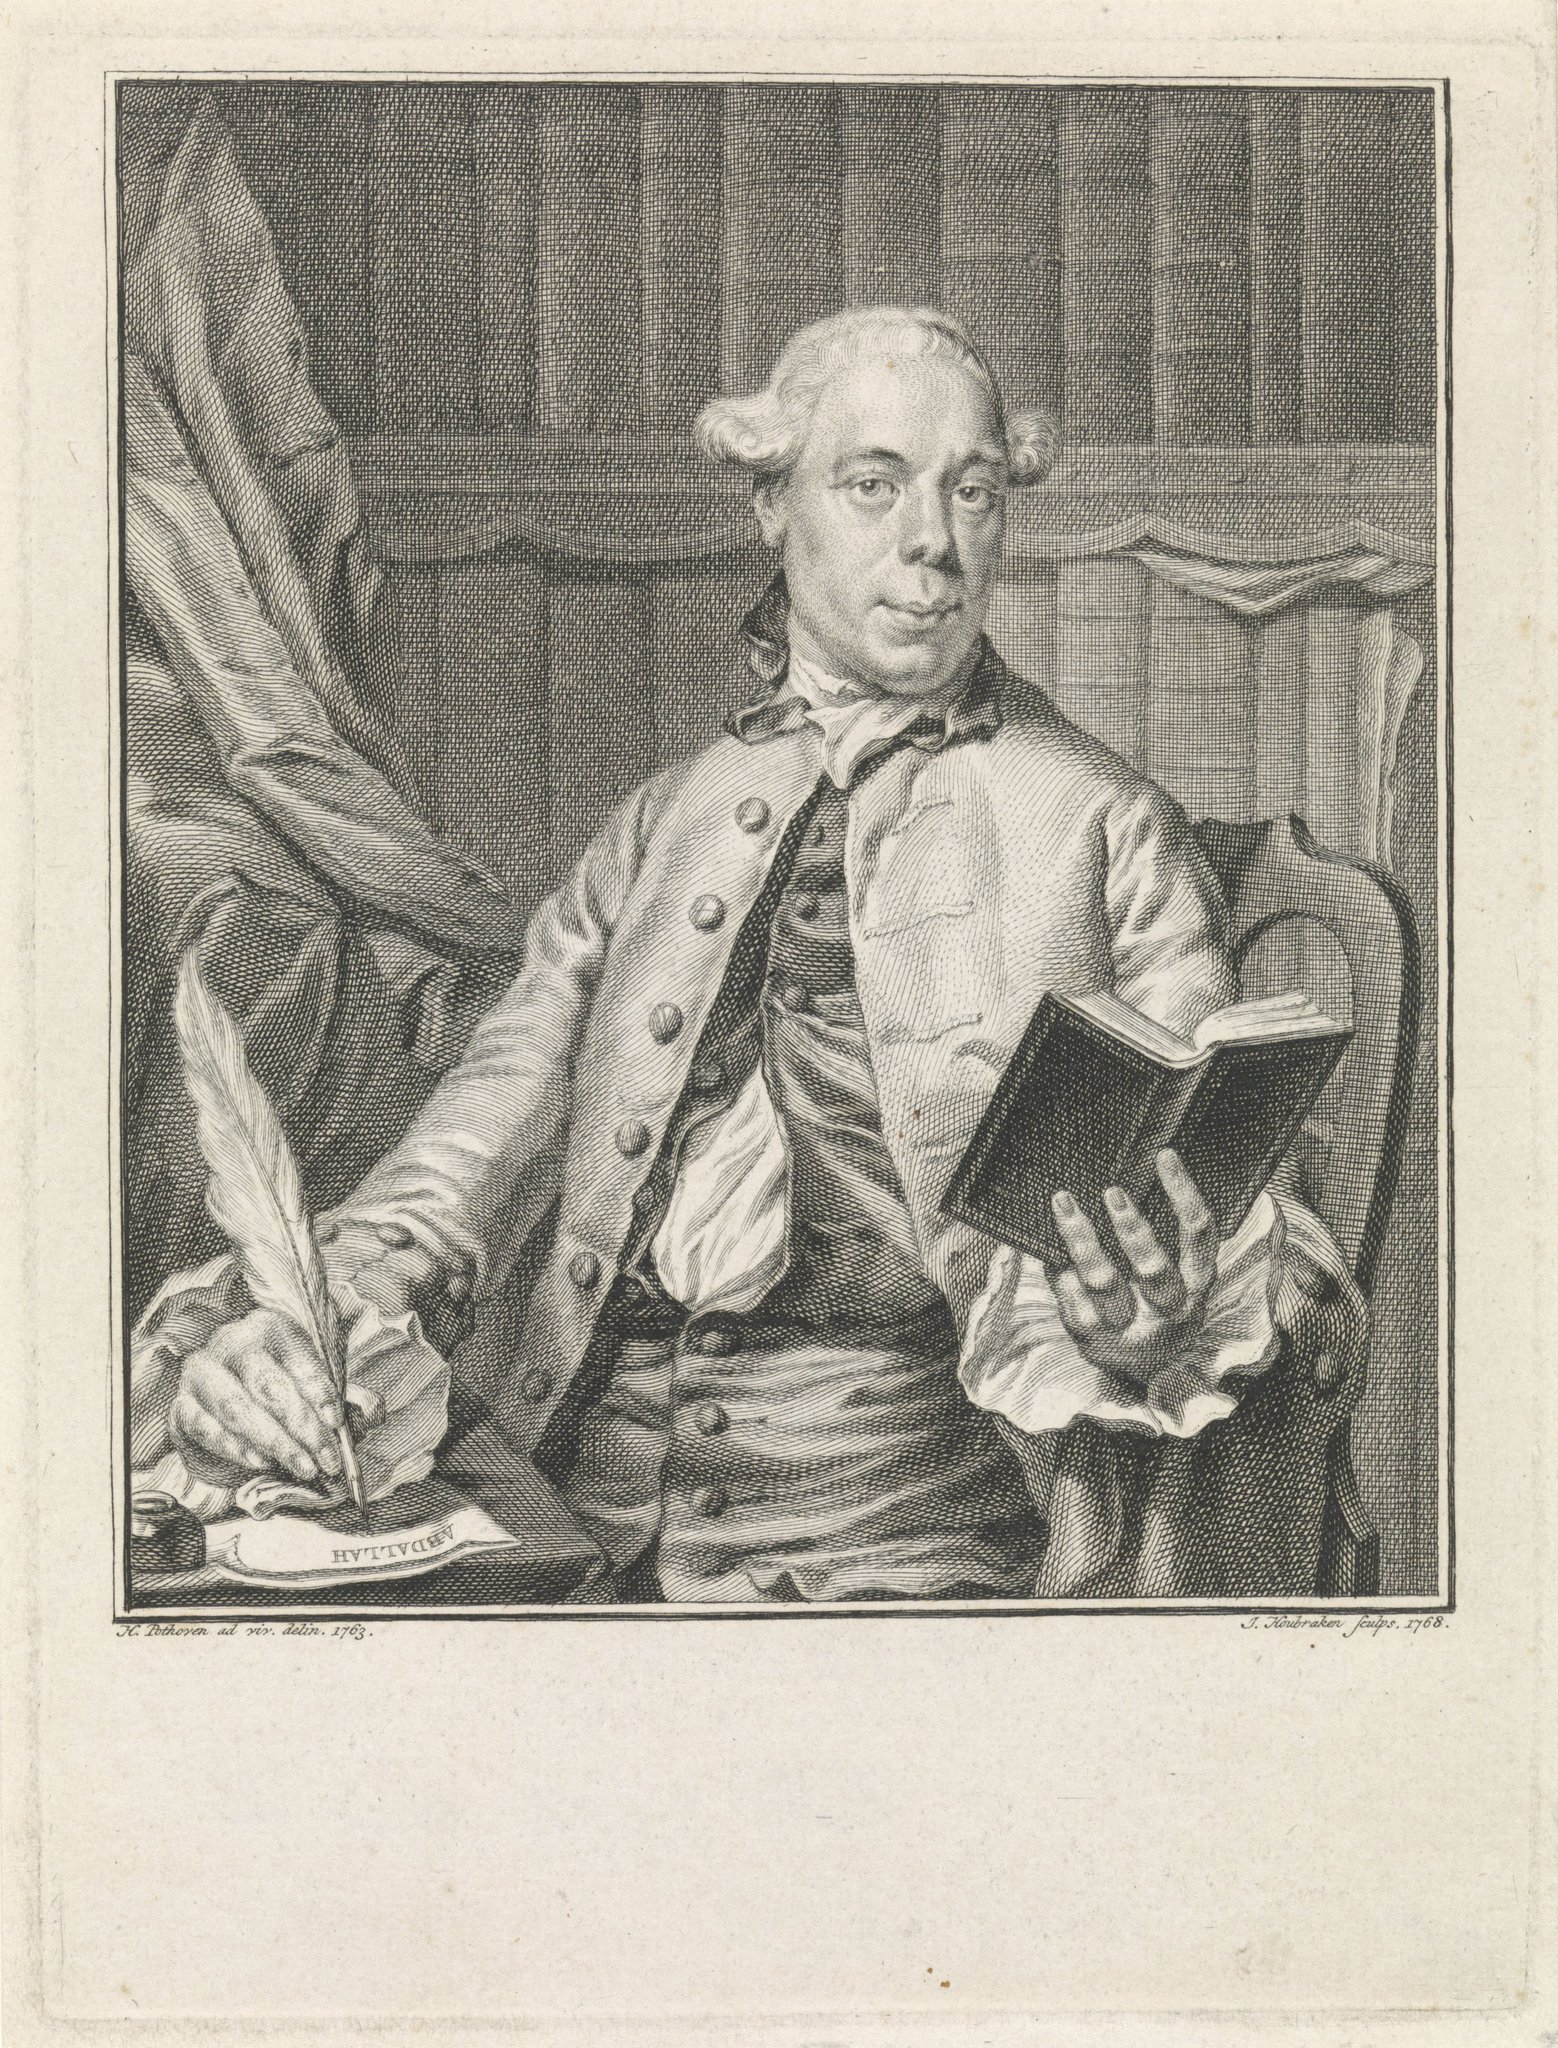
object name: print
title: Portret van Joannes Nomsz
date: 1768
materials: paper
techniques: engraving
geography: amsterdam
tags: joannes nomsz, quill, study; 'studiolo'; library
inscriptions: collector's mark: Lugt 2228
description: Portret ten haalven lijve van Joannes Nomsz, zittend aan een tafel. In zijn linkerhand houdt hij een boek vast en met zijn rechterhand schrijft hij met een schrijveer 'Abdallah' op een vel papier. Op de achtergrond een gordijn en een boekenkast.